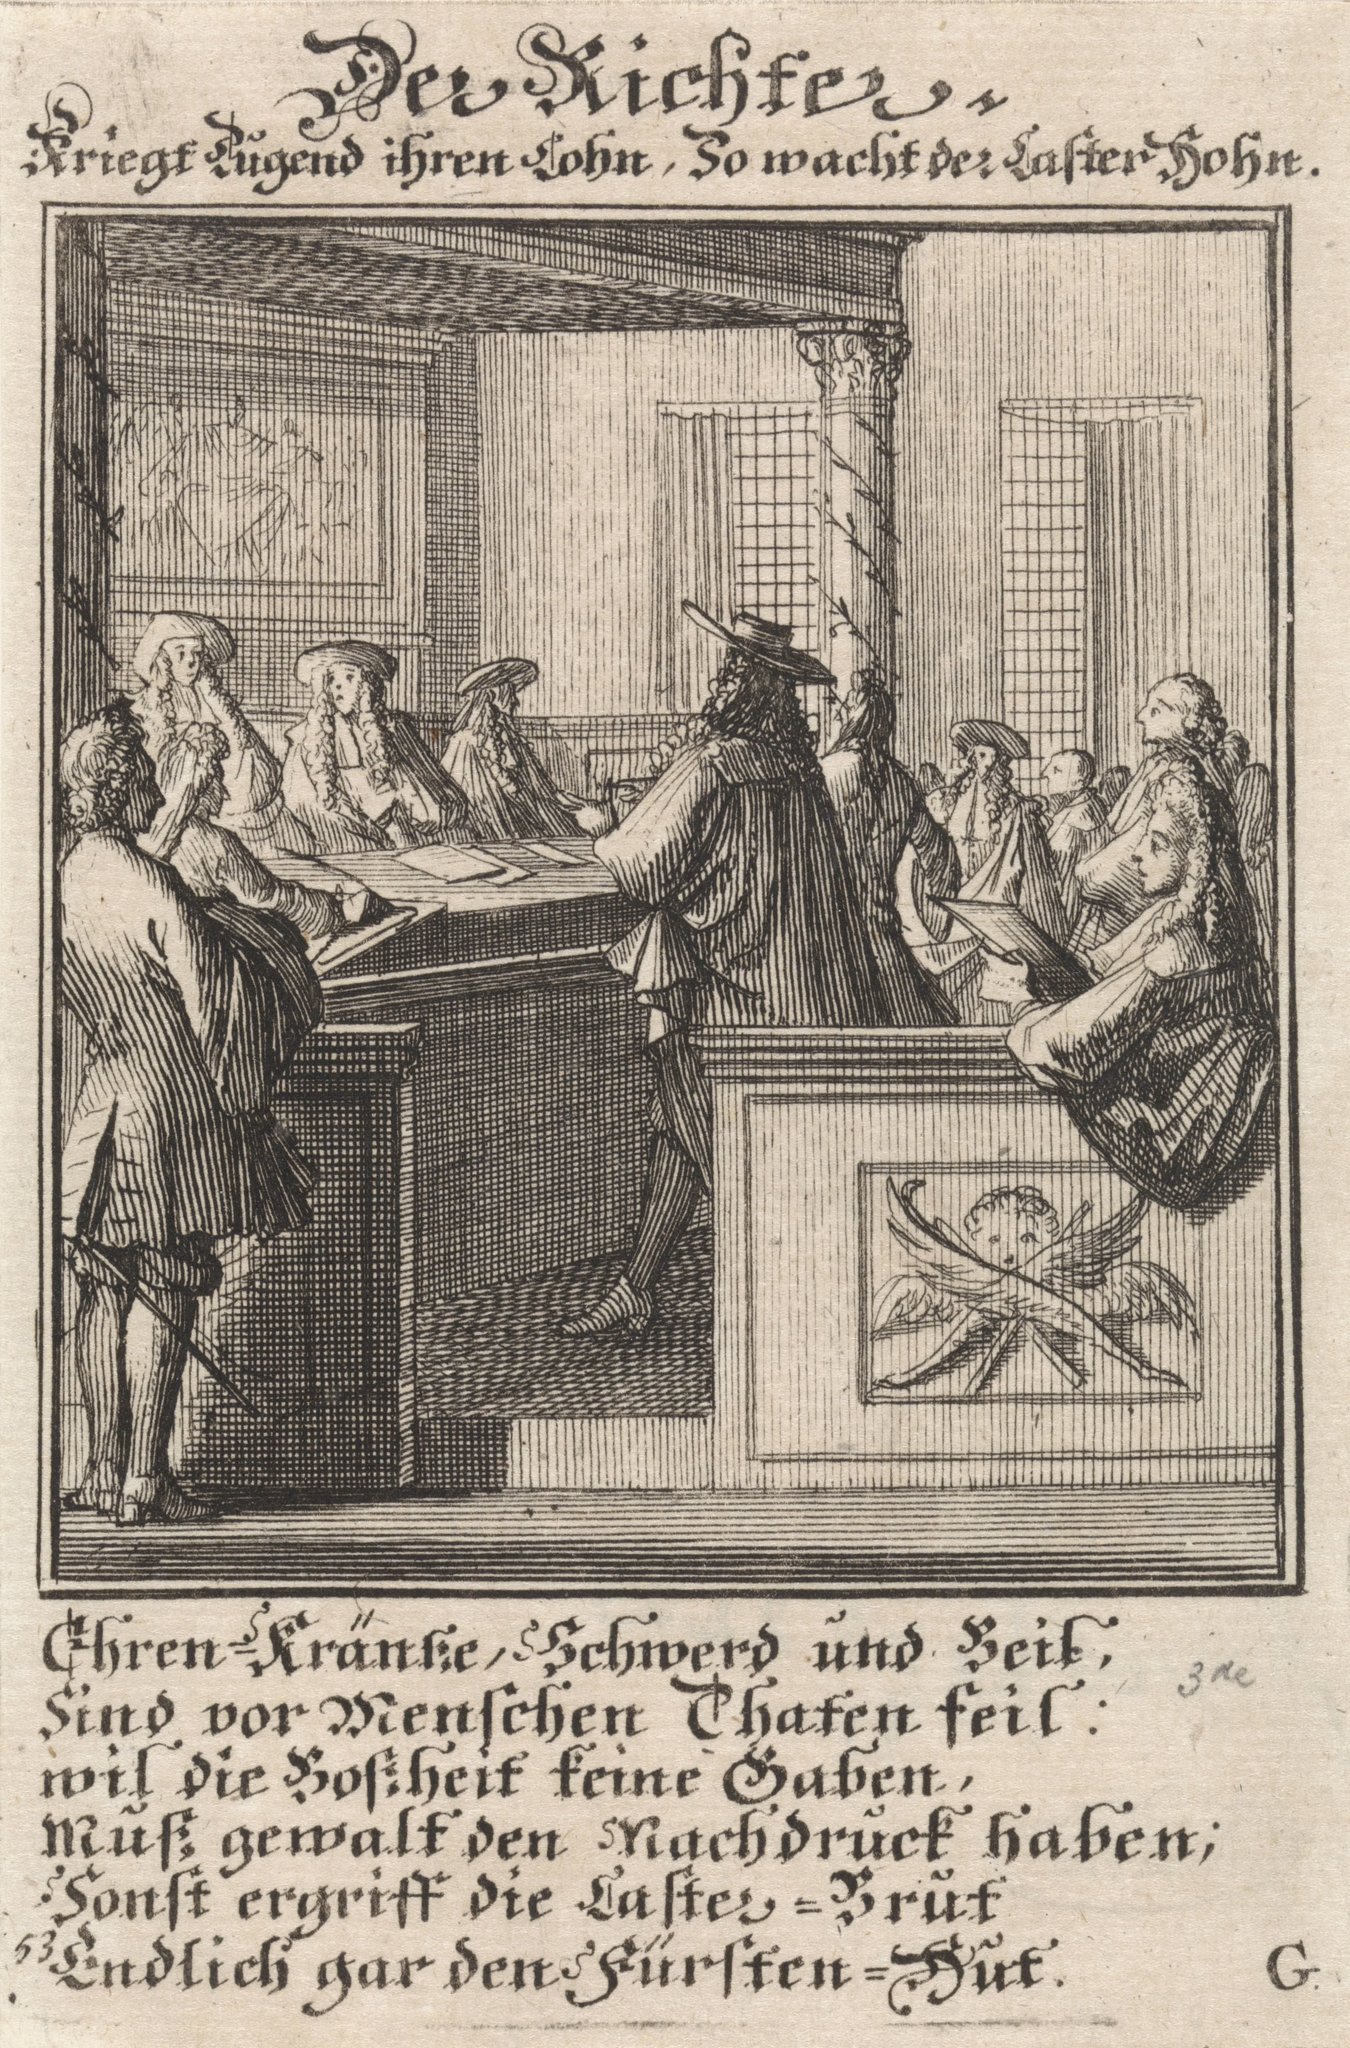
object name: print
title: Der Richter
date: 1711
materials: paper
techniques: etching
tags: magistracy, judges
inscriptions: collector's mark: Lugt 2228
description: Illustratie uit: Sancta Clara, Abraham à. Etwas für Alle, das ist: Eine kurtze Beschreibung allerley Stands- Ambts- und Gewerbs-Persohnen (...), 3 delen (1699-1733). Würtzburg: Martin Frantz Hertz, 1711, dl. III, p. 498. Het betreft hier de tweede druk van deel III.